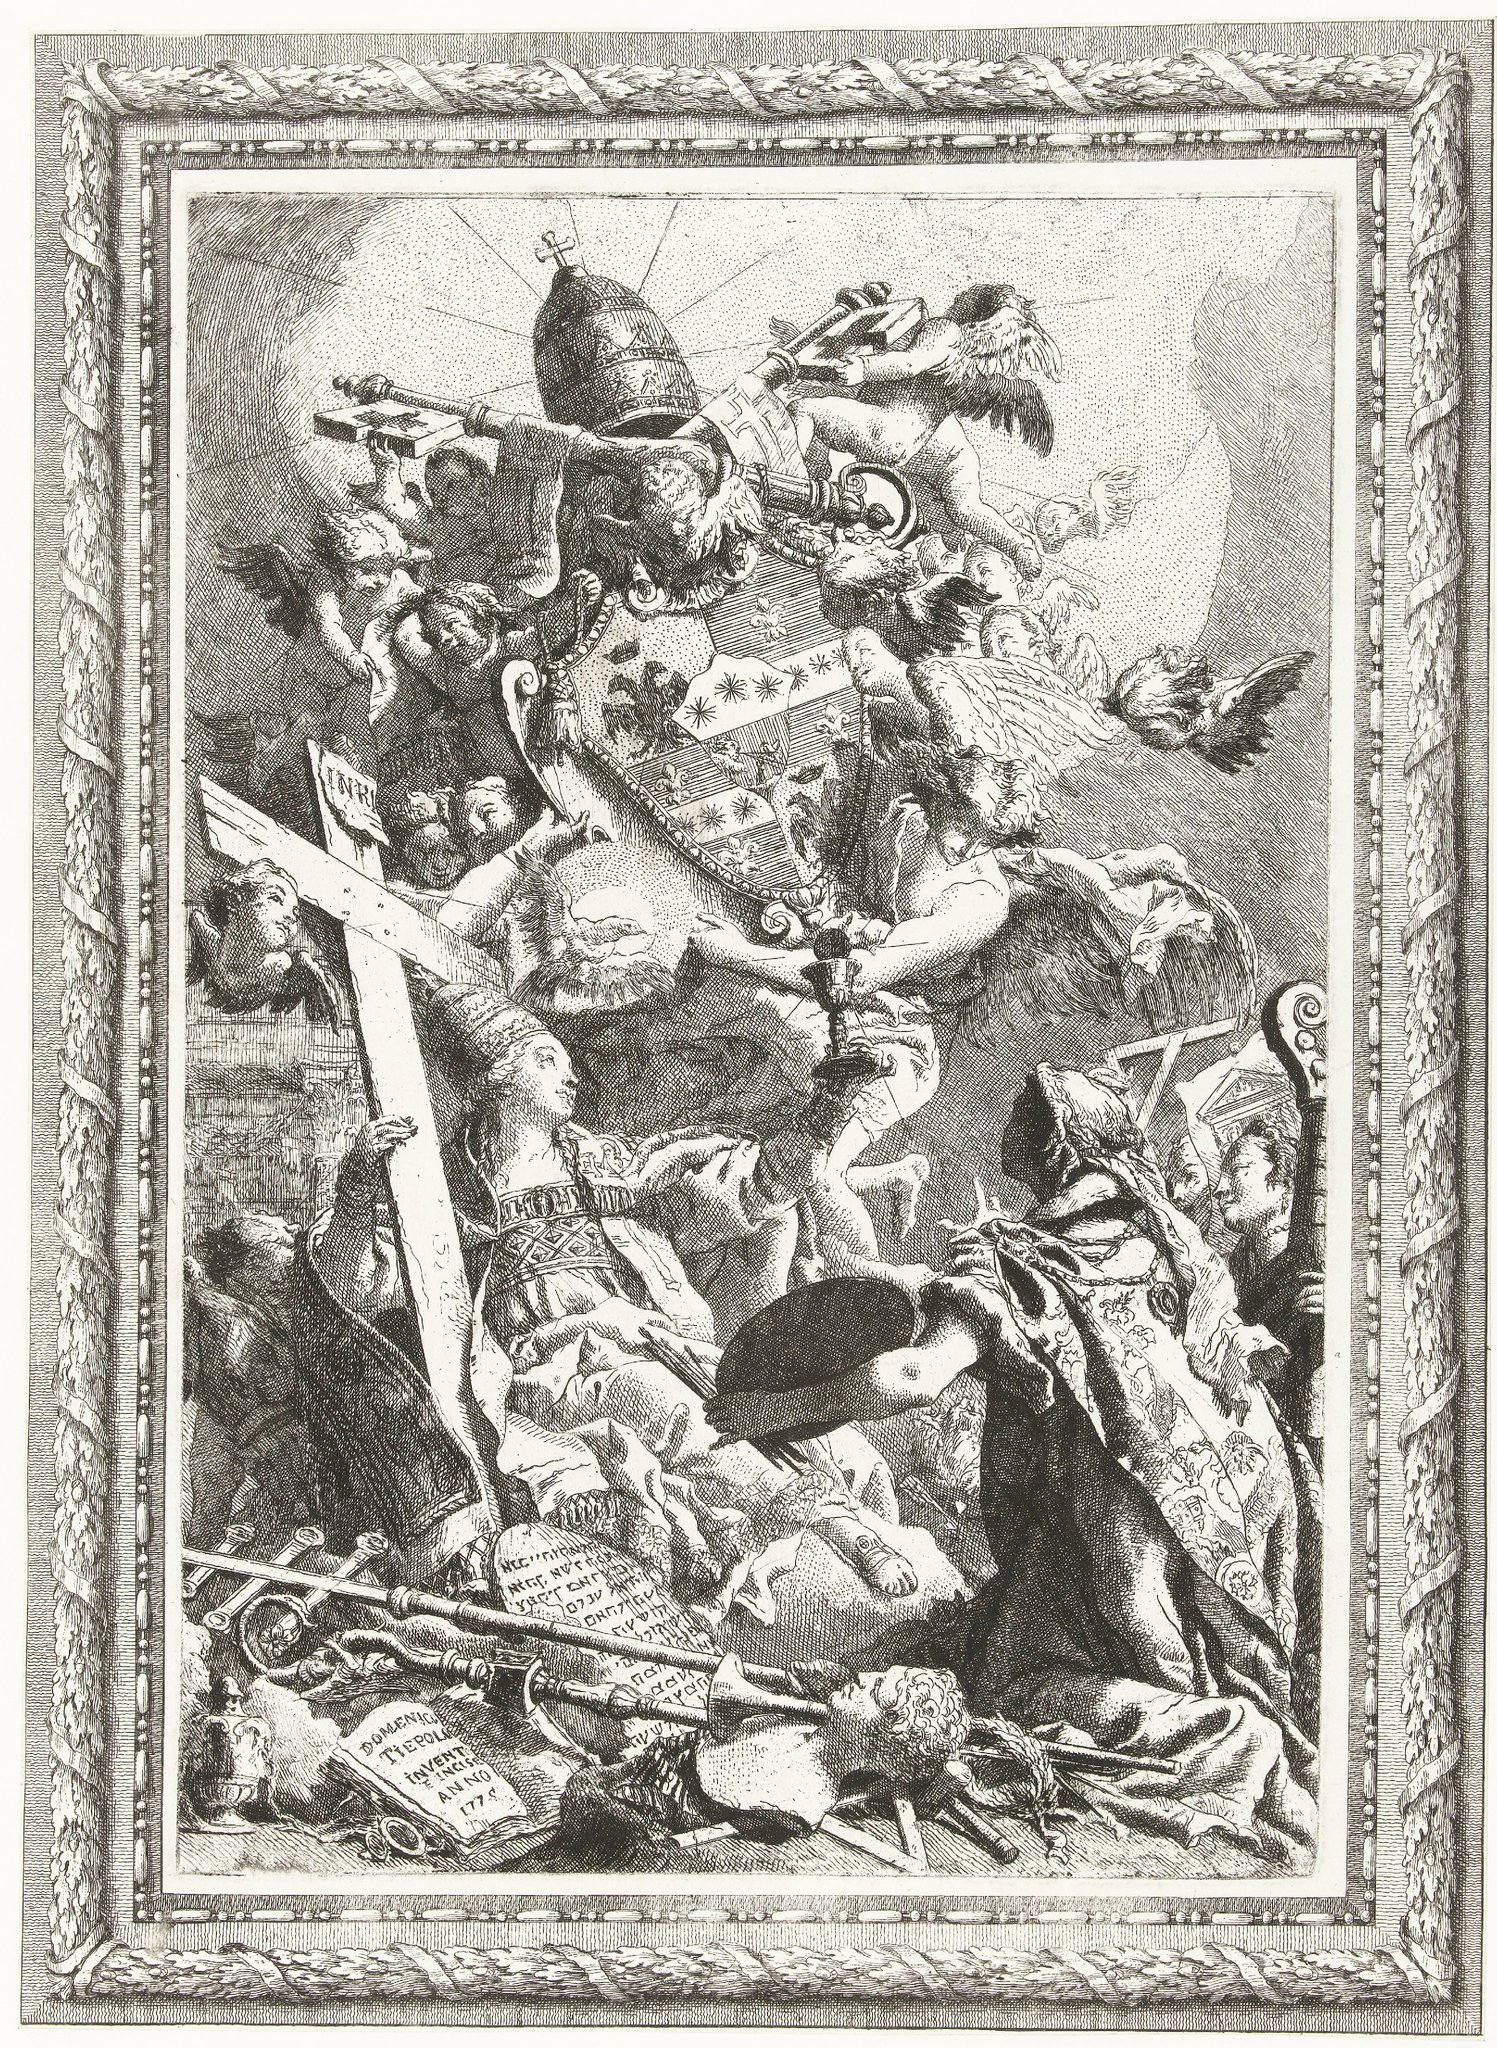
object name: print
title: Titelprent voor de verzamelde werken van Giovanni Battista, Giovanni Domenico en Lorenzo Baldissare Tiepolo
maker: giovanni domenico tiepolo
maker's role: draughtsman, print maker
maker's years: 1727-1804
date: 1775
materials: paper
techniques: etching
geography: venice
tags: pius vi, the liberal arts, 'artes liberales', insignia of the pope, e.g. tiara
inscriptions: collector's mark: Lugt 2228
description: Titelprent voor: Verzamelde werken van Giovanni Battista, Giovanni Domenico en Lorenzo Baldissera Tiepolo, G.D. Tiepolo (uitgever), Venetië 1775. Giovanni Domenico Tiepolo baseerde zich op verschillende werken, ook van zijn vader, en voegde figuren samen tot deze compositie (zie Knox 1976, p. 130, nr. 209).